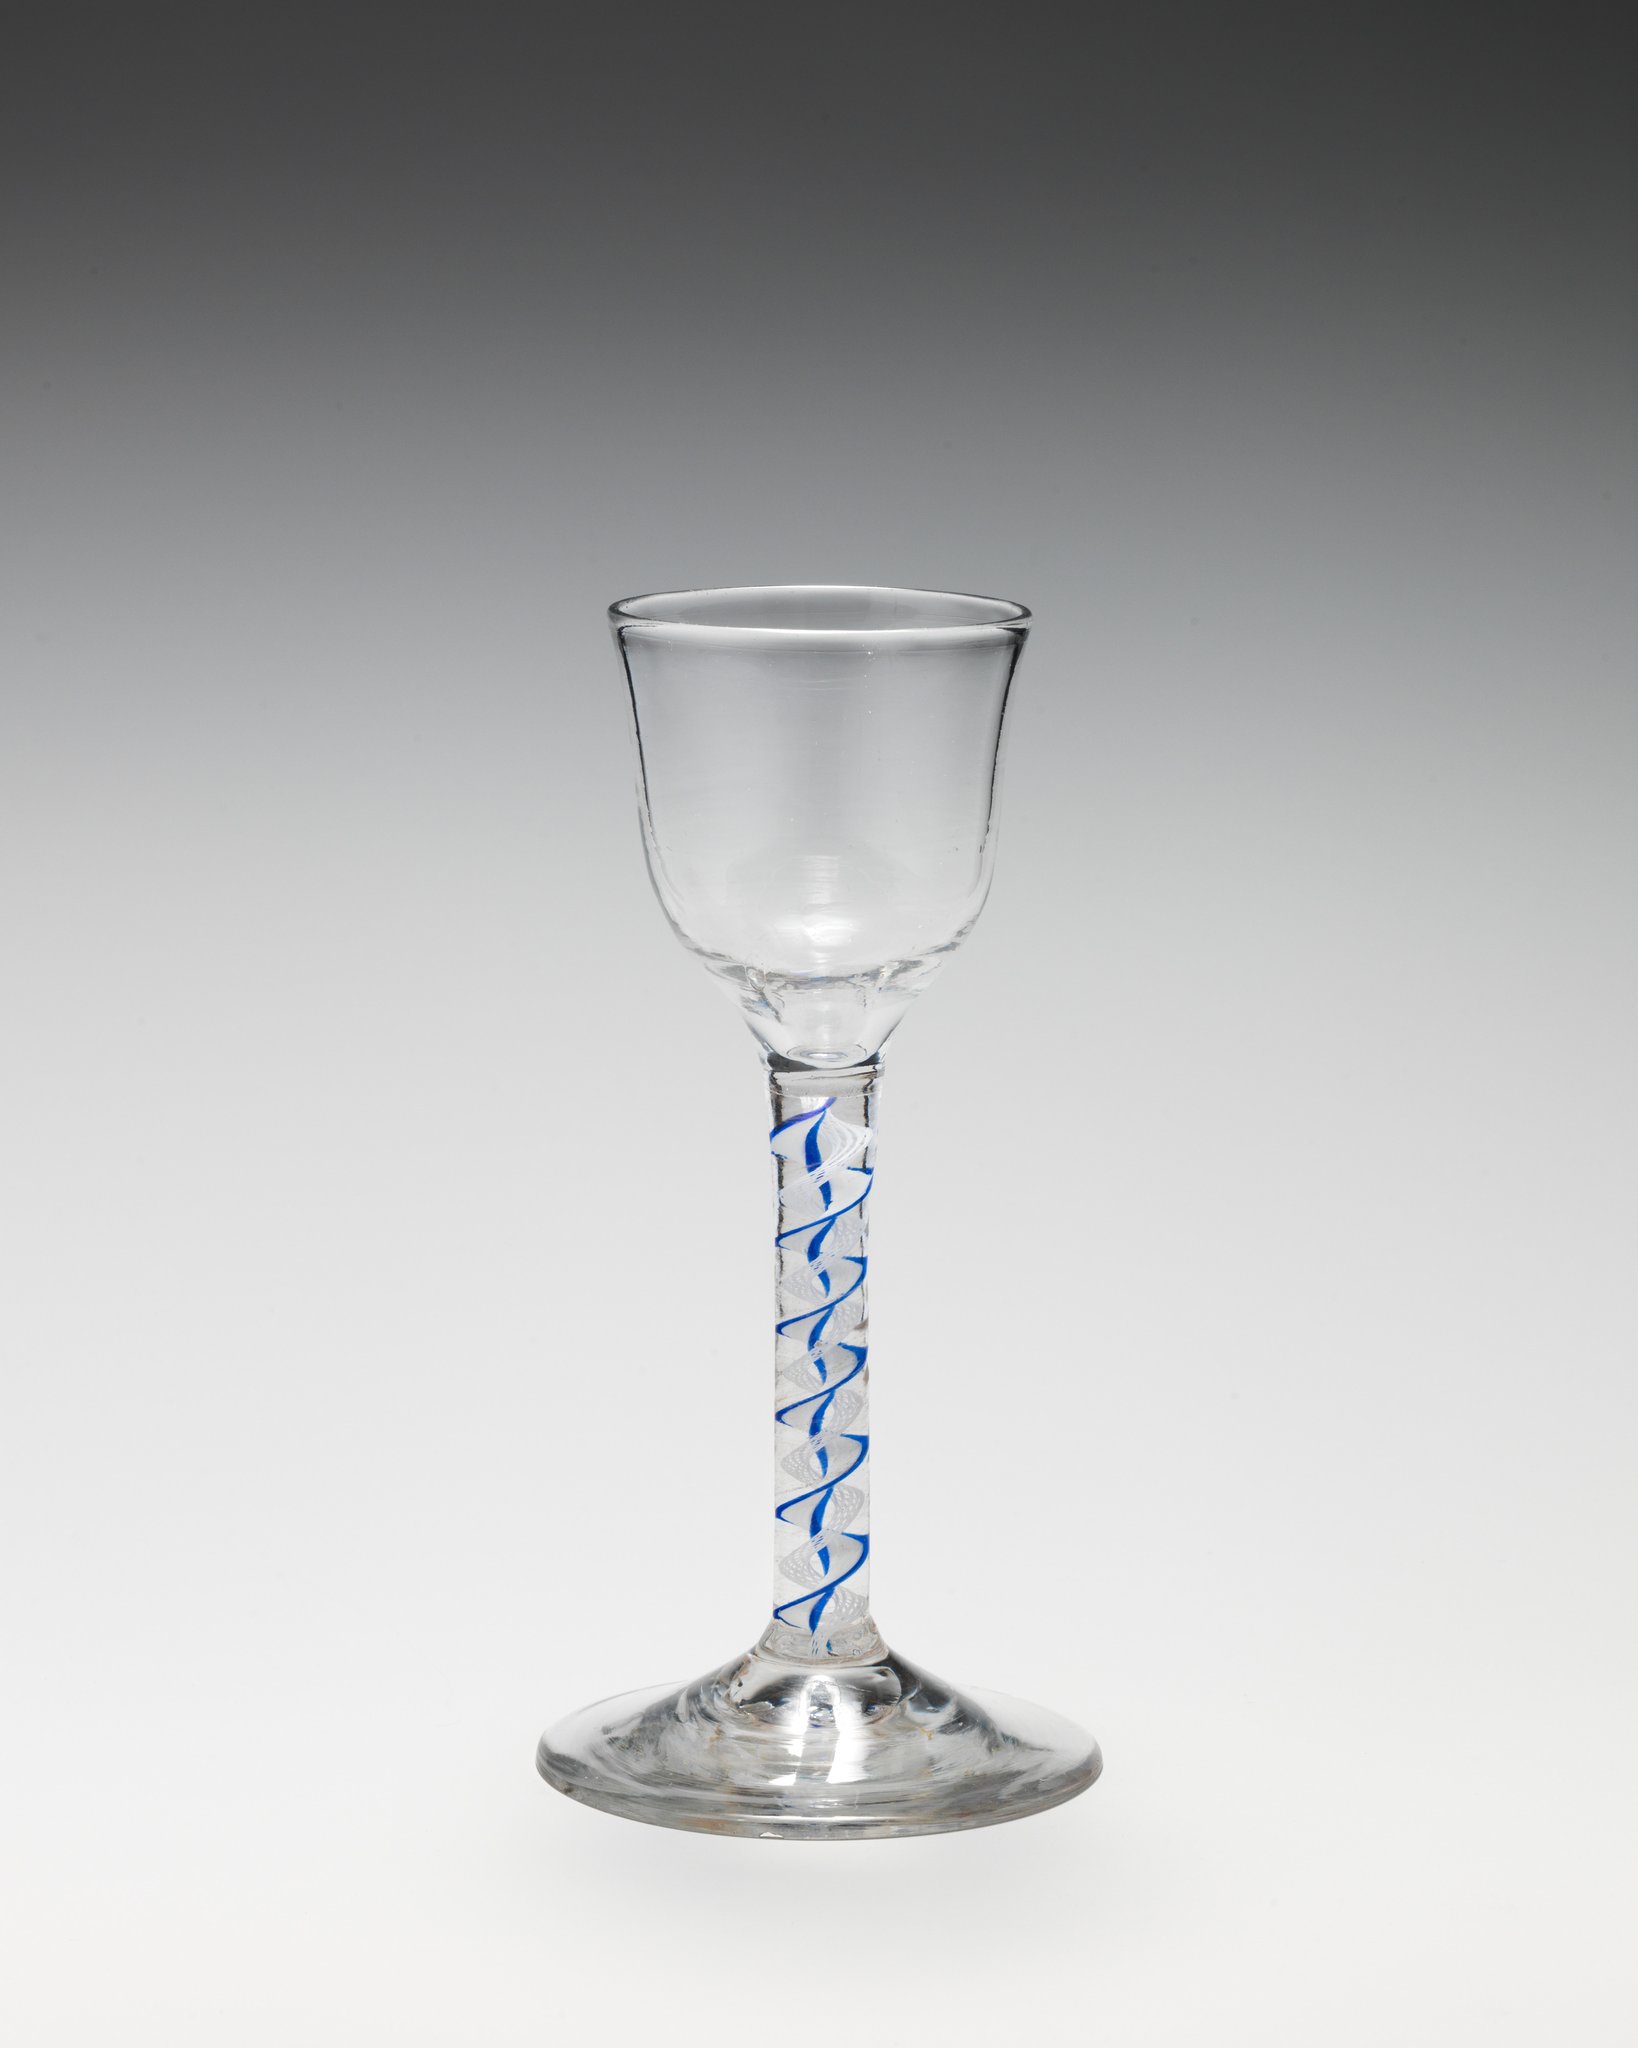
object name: wineglass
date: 1770-1800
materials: glass